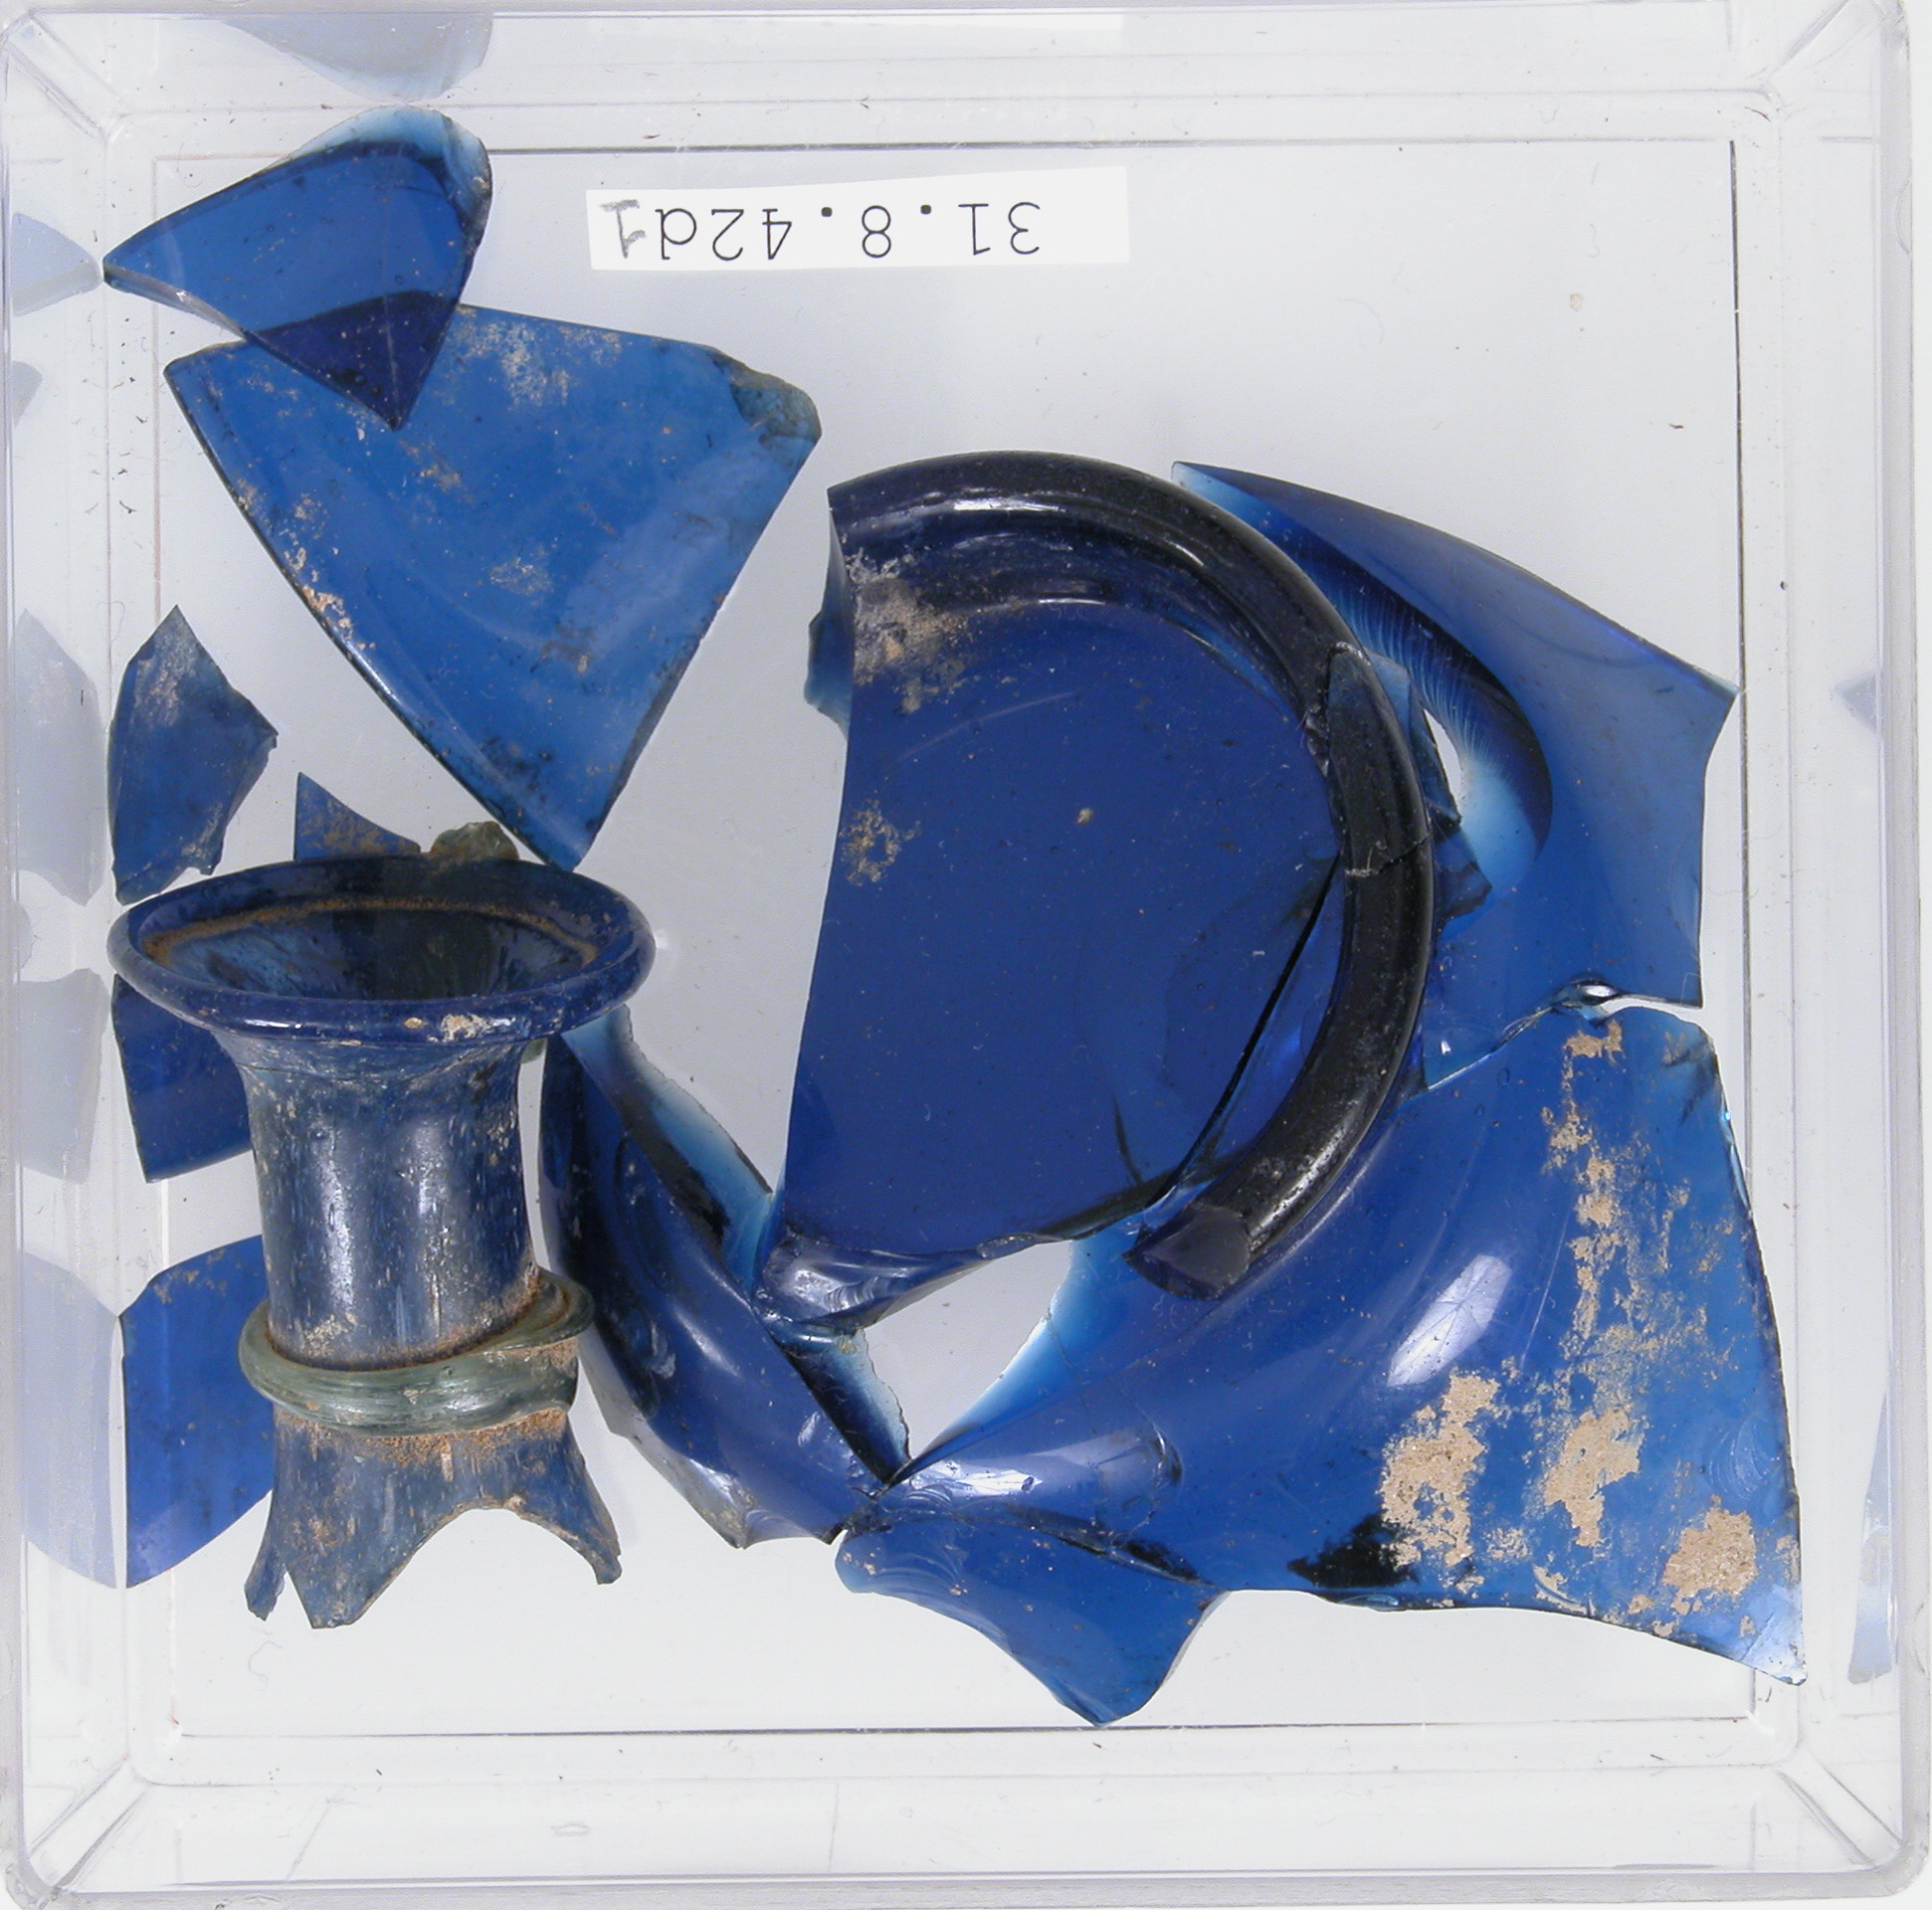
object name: fragment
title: Glass Fragments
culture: coptic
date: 301-400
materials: glass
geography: egypt